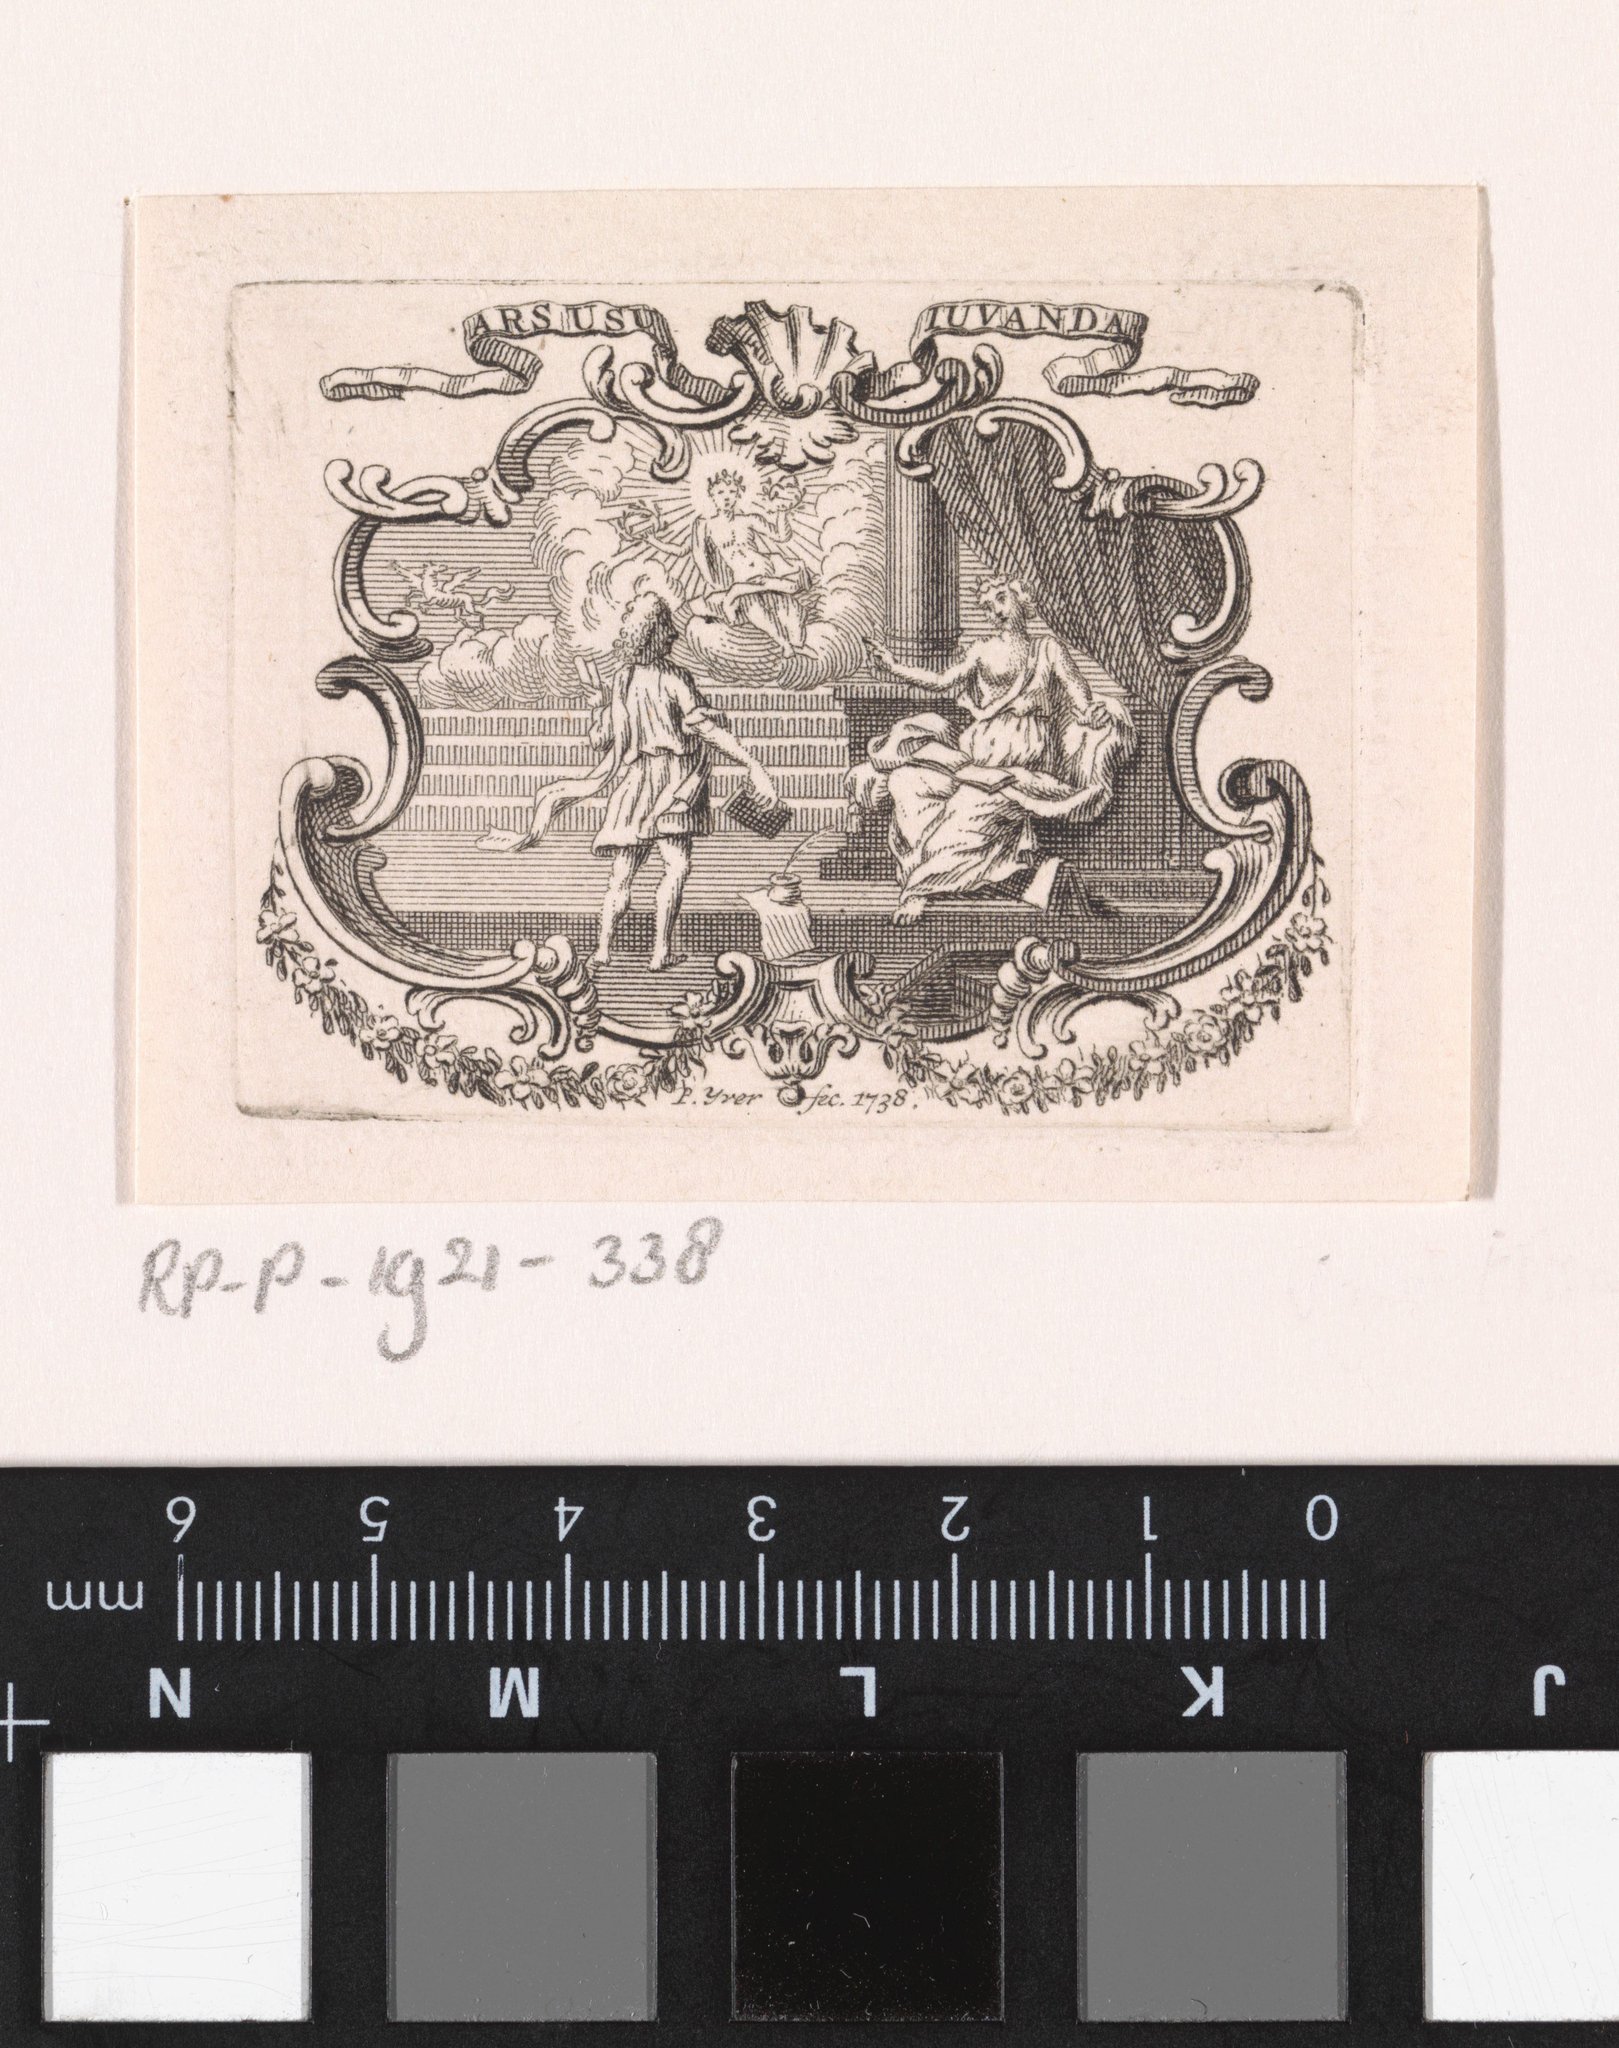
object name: print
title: Schrijver en muse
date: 1738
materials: paper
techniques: engraving, etching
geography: amsterdam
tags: the poet and his muse, (story of) apollo (phoebus)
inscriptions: collector's mark: Lugt 2233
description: Een schrijver staat voor een muze. Op de achtergrond Apollo op de Olympus. De voorstelling is gevat in een ornamentele lijst. Uitgeversvignet van Etienne Néaulme te Utrecht. Bovenaan zijn devies: Ars Usu Iuvanda.